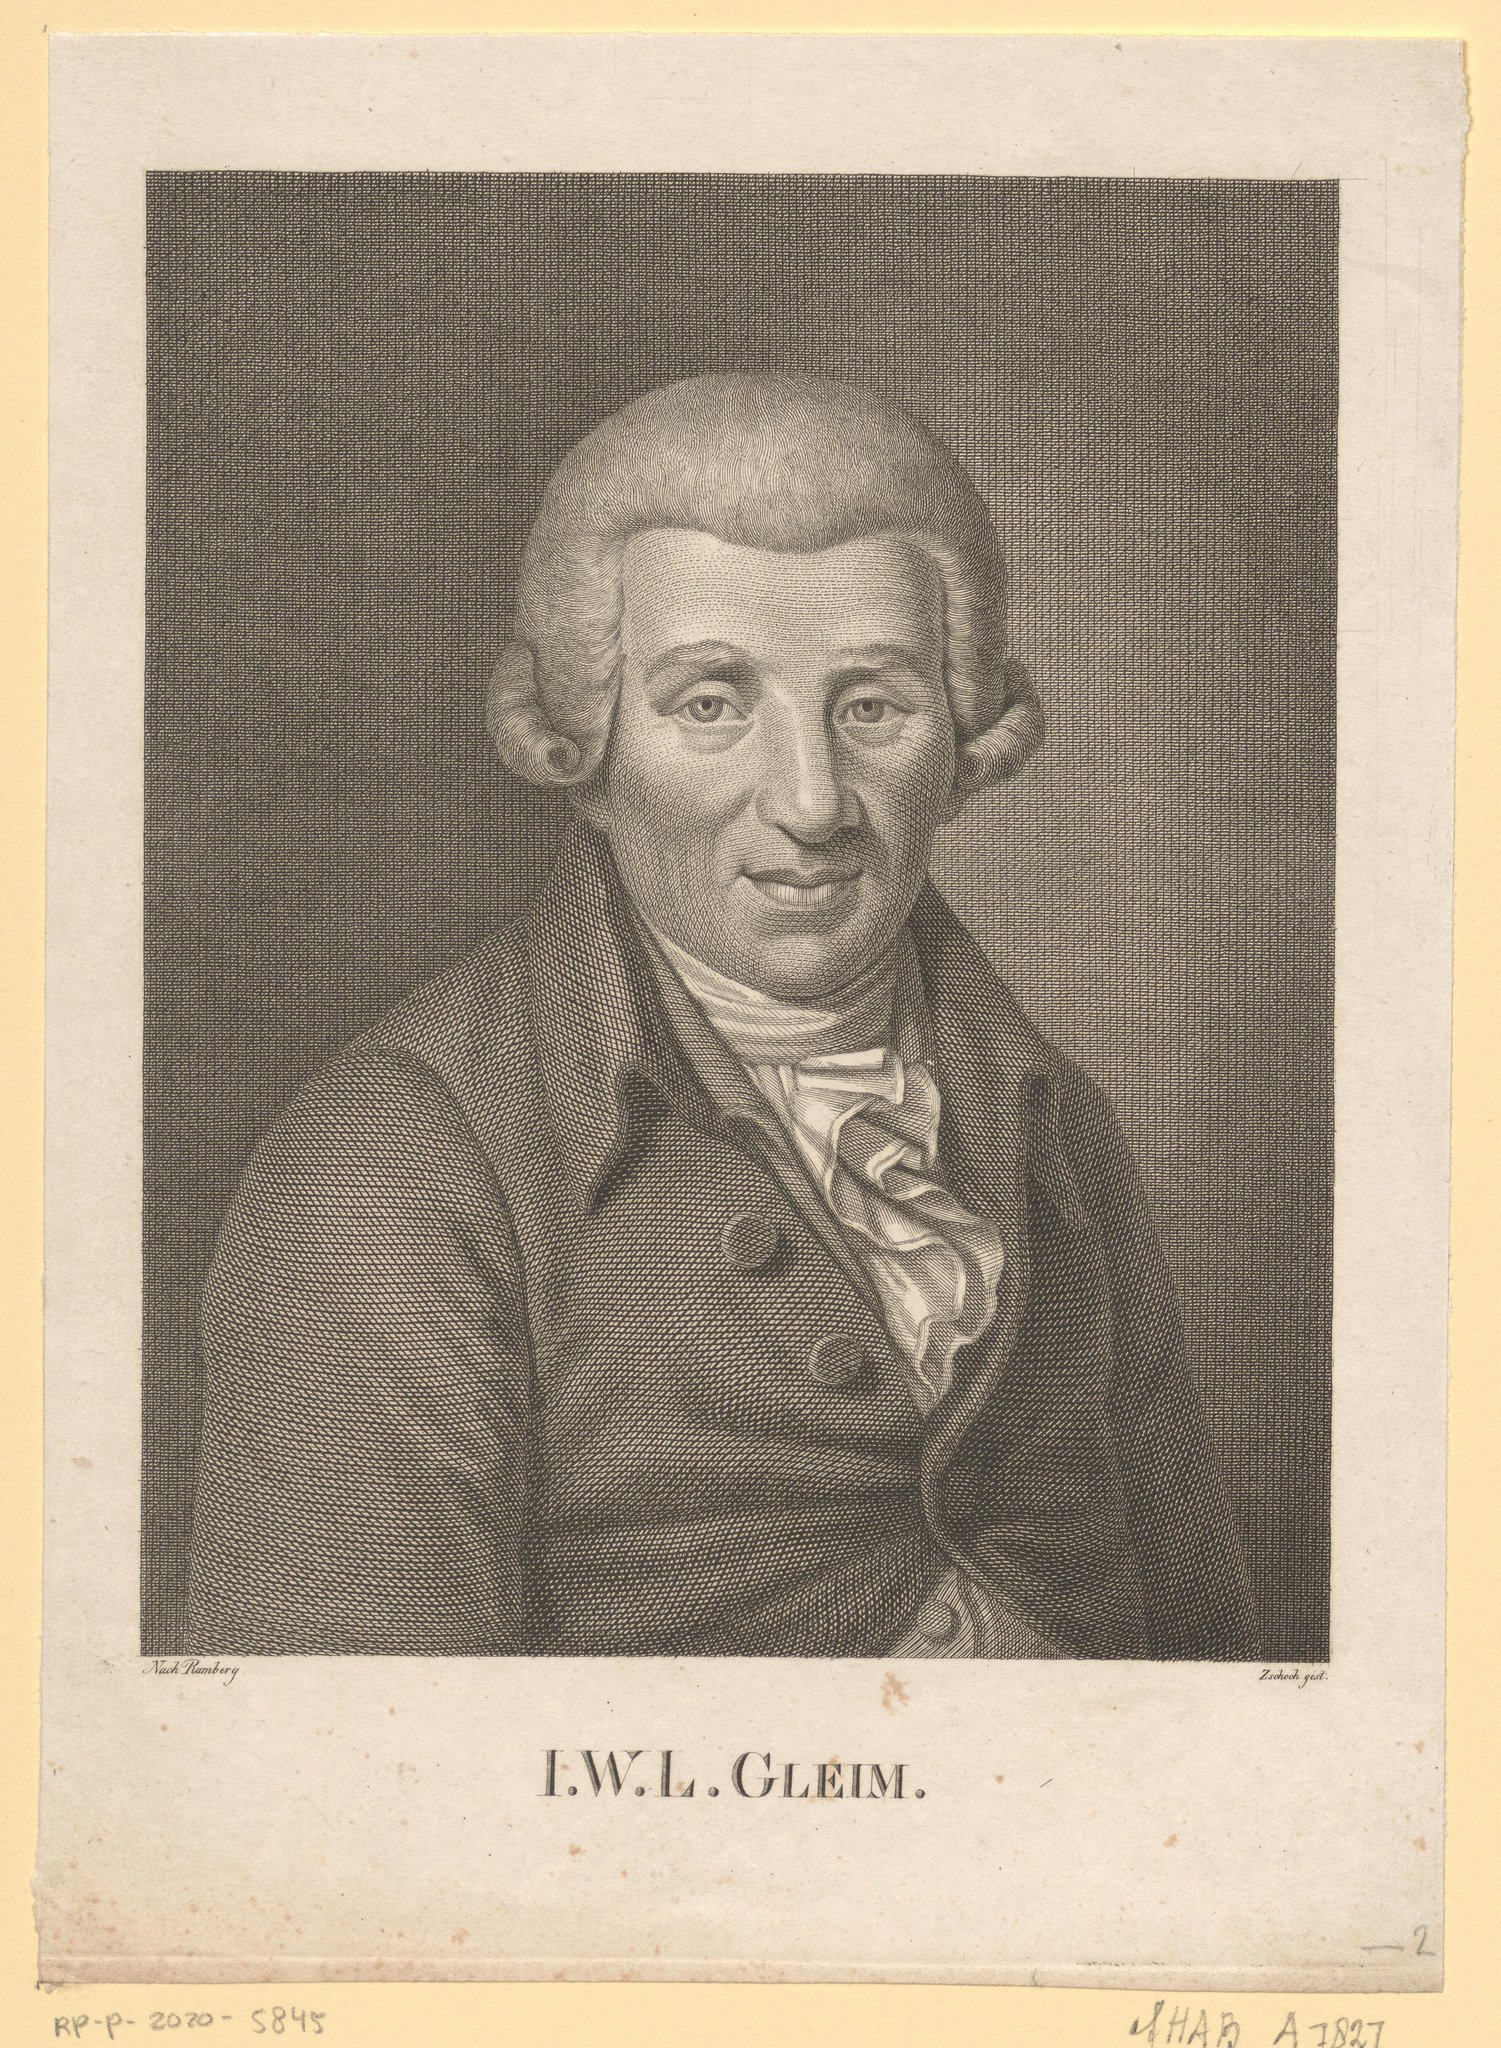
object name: print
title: Portret van Johann Wilhelm Ludwig Gleim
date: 1785-1833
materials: paper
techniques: engraving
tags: theologian, historical persons, portrait of a writer